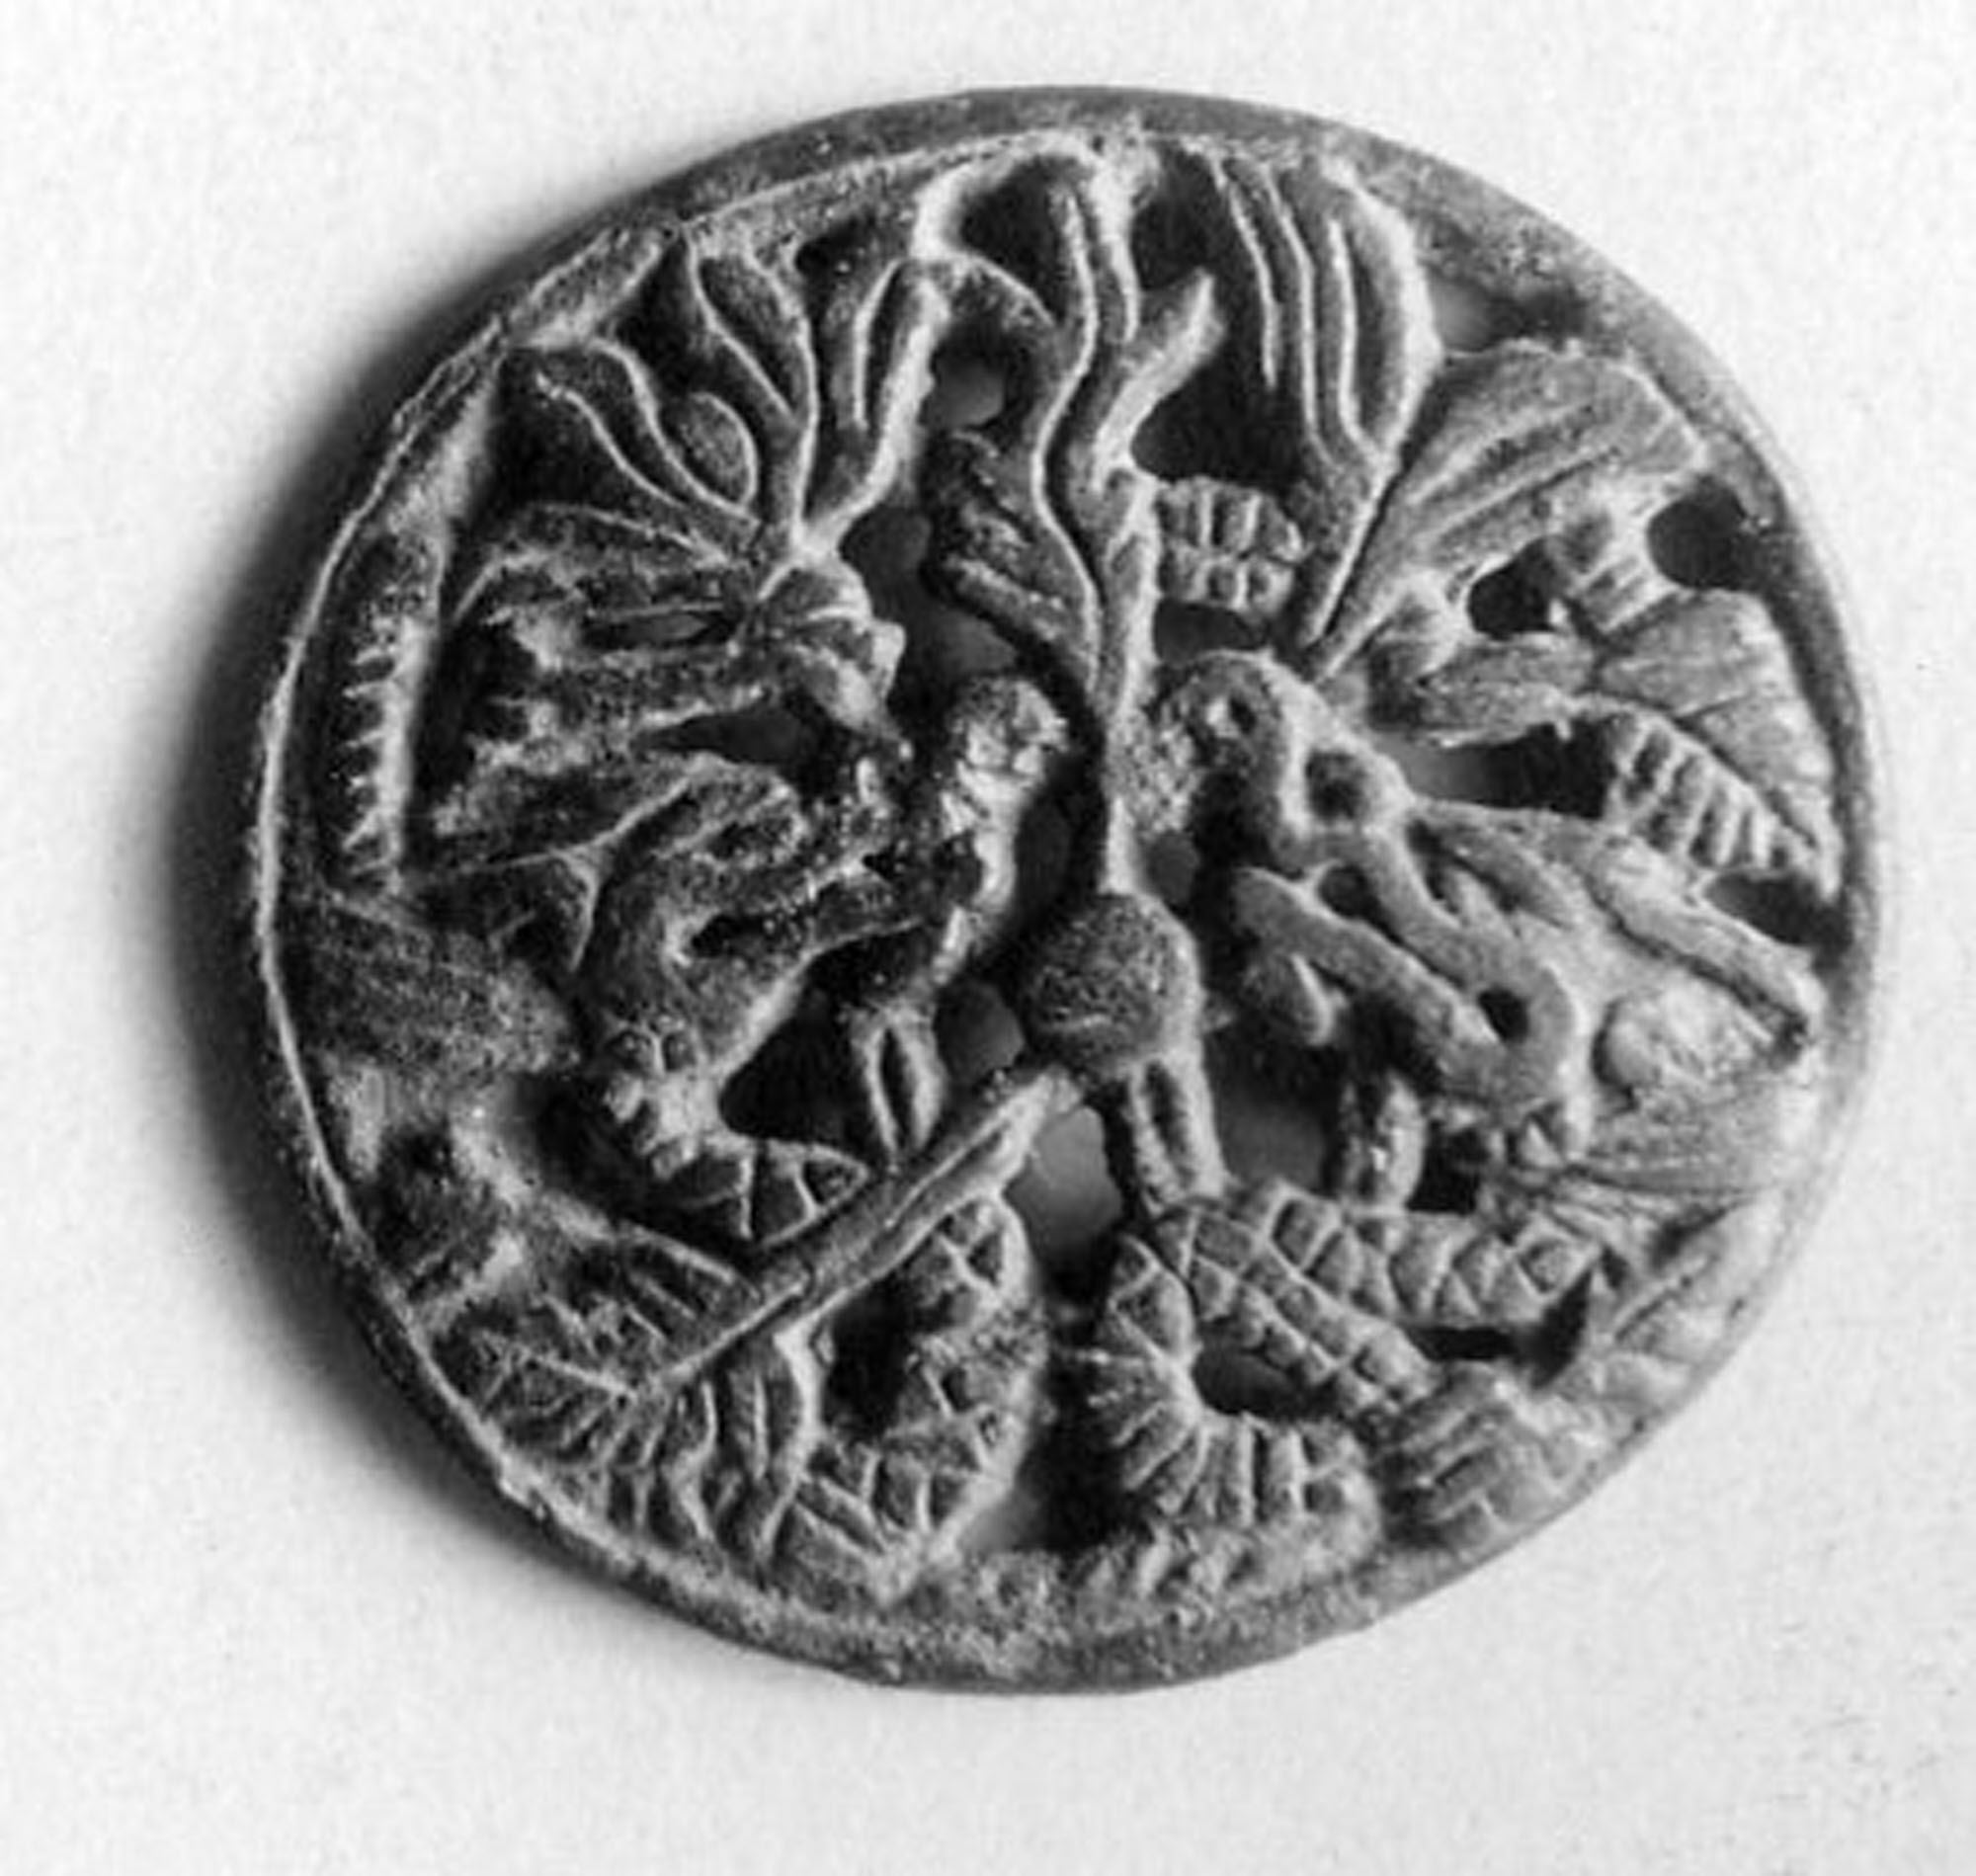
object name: belt plaque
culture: chinese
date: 201-600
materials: bronze